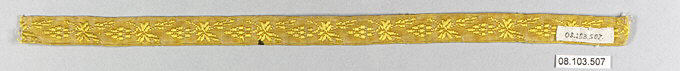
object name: galloon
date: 1701-1800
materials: cotton, silk